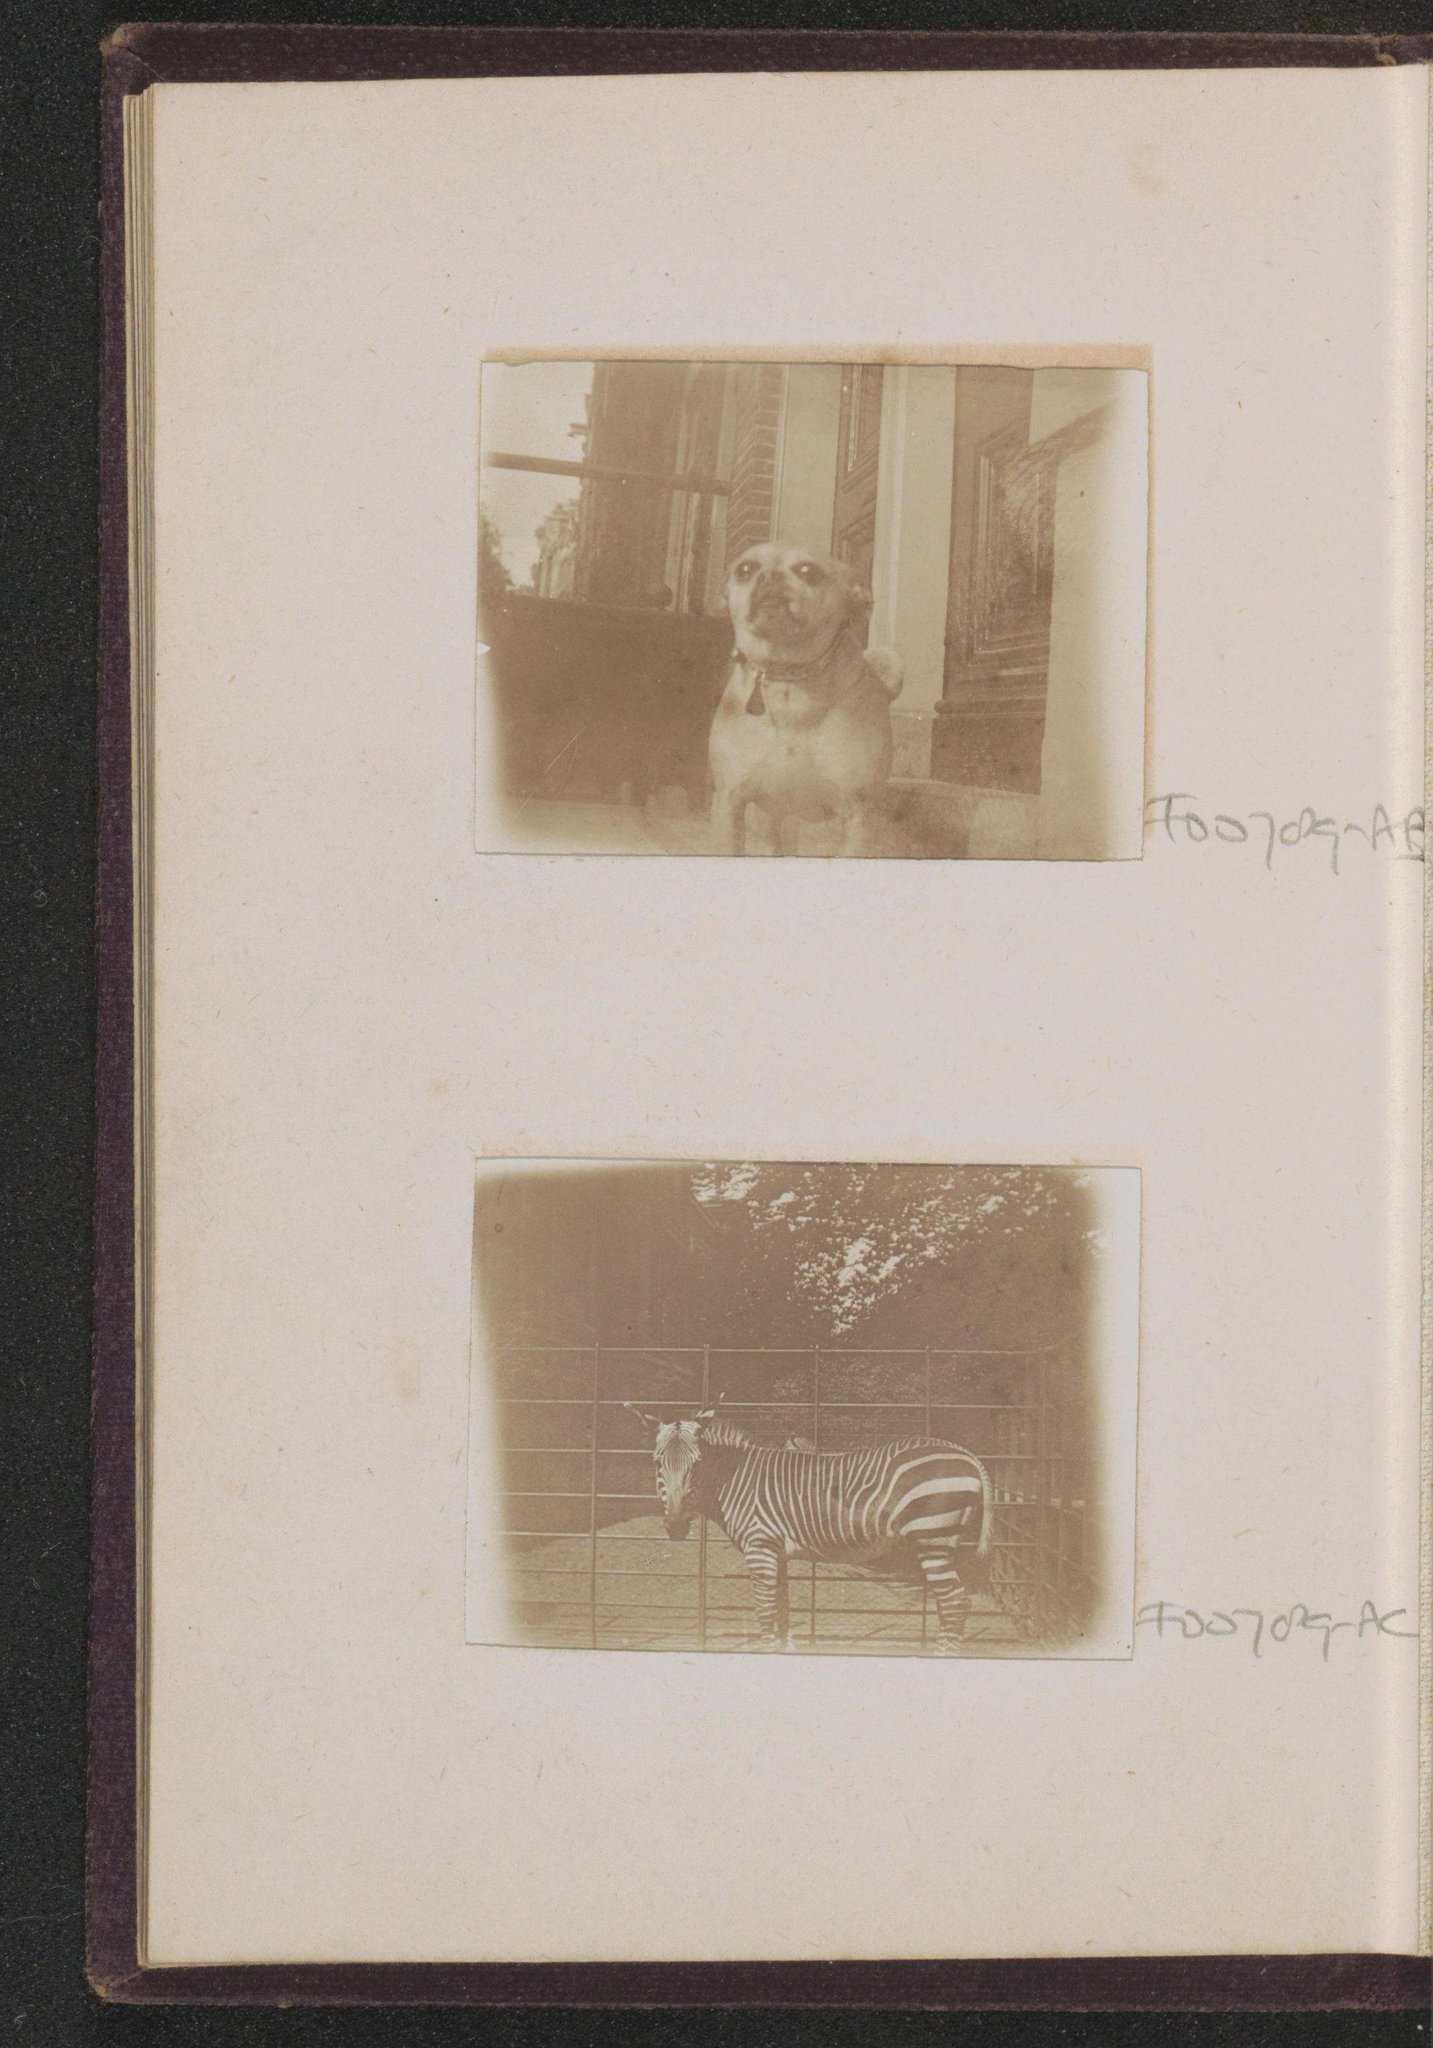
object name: contact print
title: Portret van een mopshond, staand voor een huisdeur aan een gracht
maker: Anonymous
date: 1890-1905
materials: paper, photographic support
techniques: collodion silver print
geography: netherlands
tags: dog, netherlands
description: Onderdeel van Fotoalbum met 35 foto's van Amsterdam, personen en dieren.